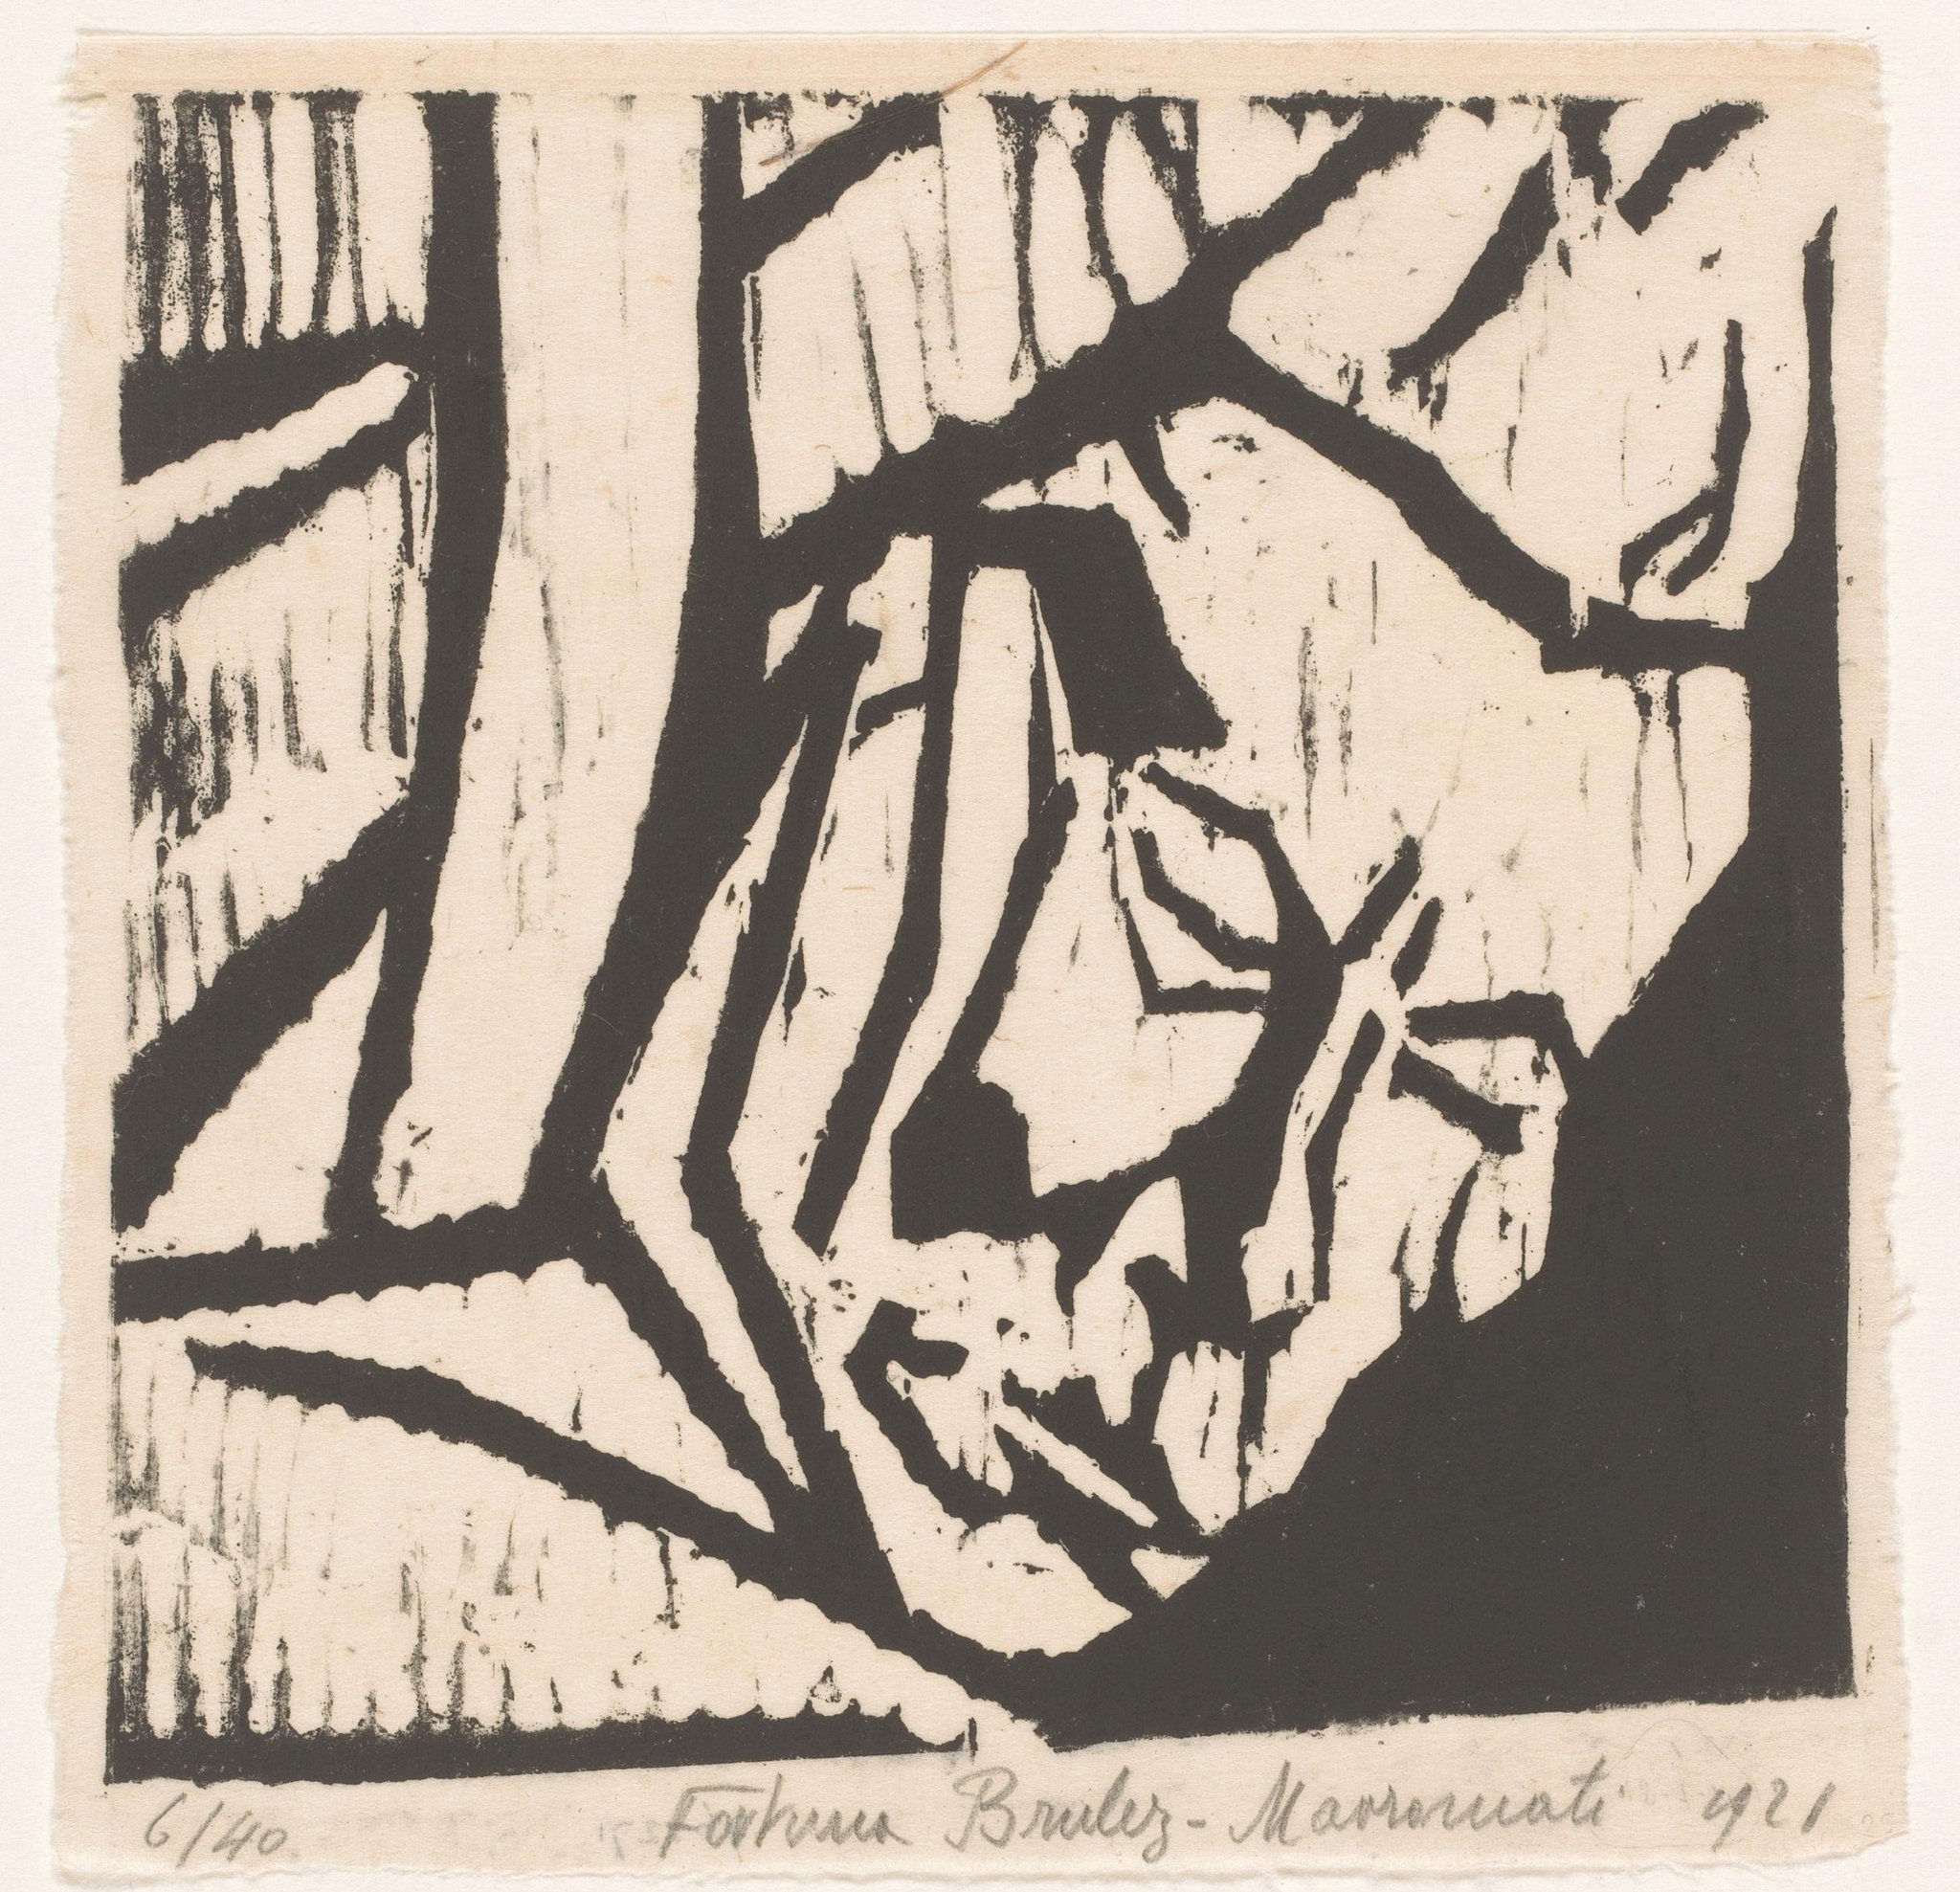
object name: print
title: Kop van een man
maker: fortuna brulez-mavromiati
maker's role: print maker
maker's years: 1893-1953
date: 1921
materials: paper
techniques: woodcut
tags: head (human)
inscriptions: date